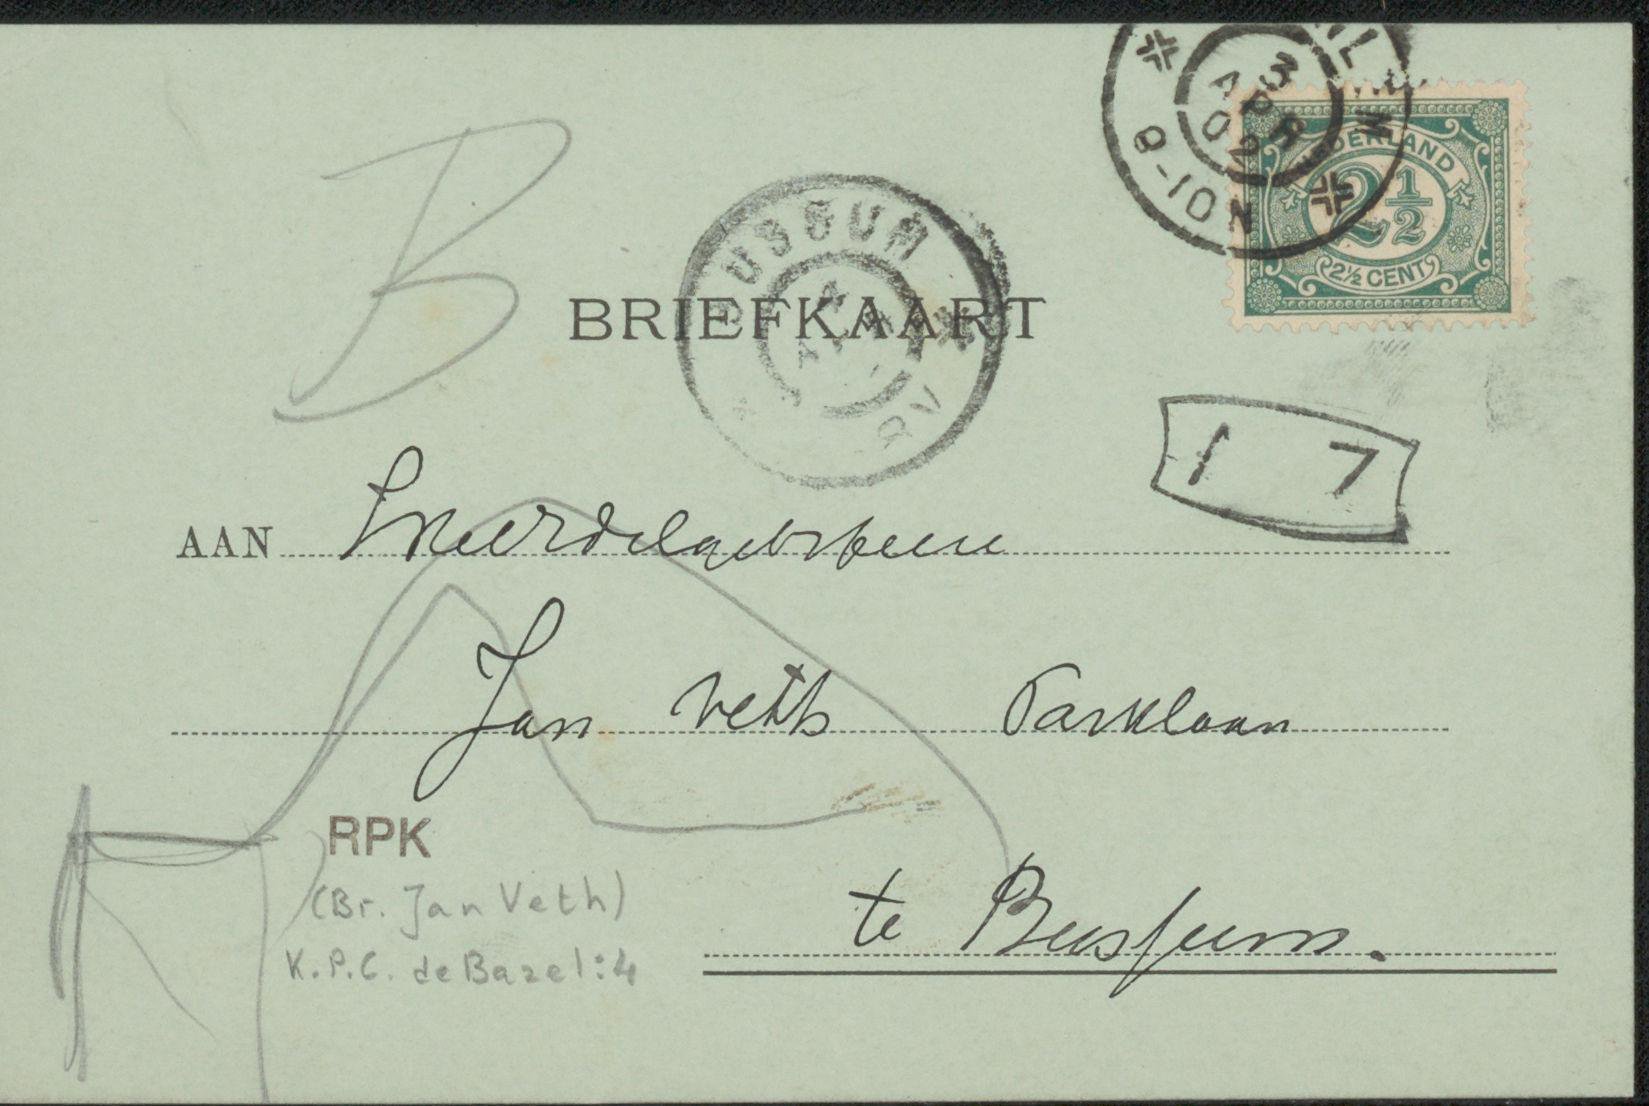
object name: postcard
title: Briefkaart aan Jan Veth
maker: karel petrus cornelis de bazel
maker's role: draughtsman, print maker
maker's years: 1869-1923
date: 1902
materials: cardboard, ink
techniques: pen, writing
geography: santpoort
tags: dordrecht, painter, designer, jan veth, door, architecture, exterior ~ architectural design or model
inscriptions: collector's mark: ‘RPK’